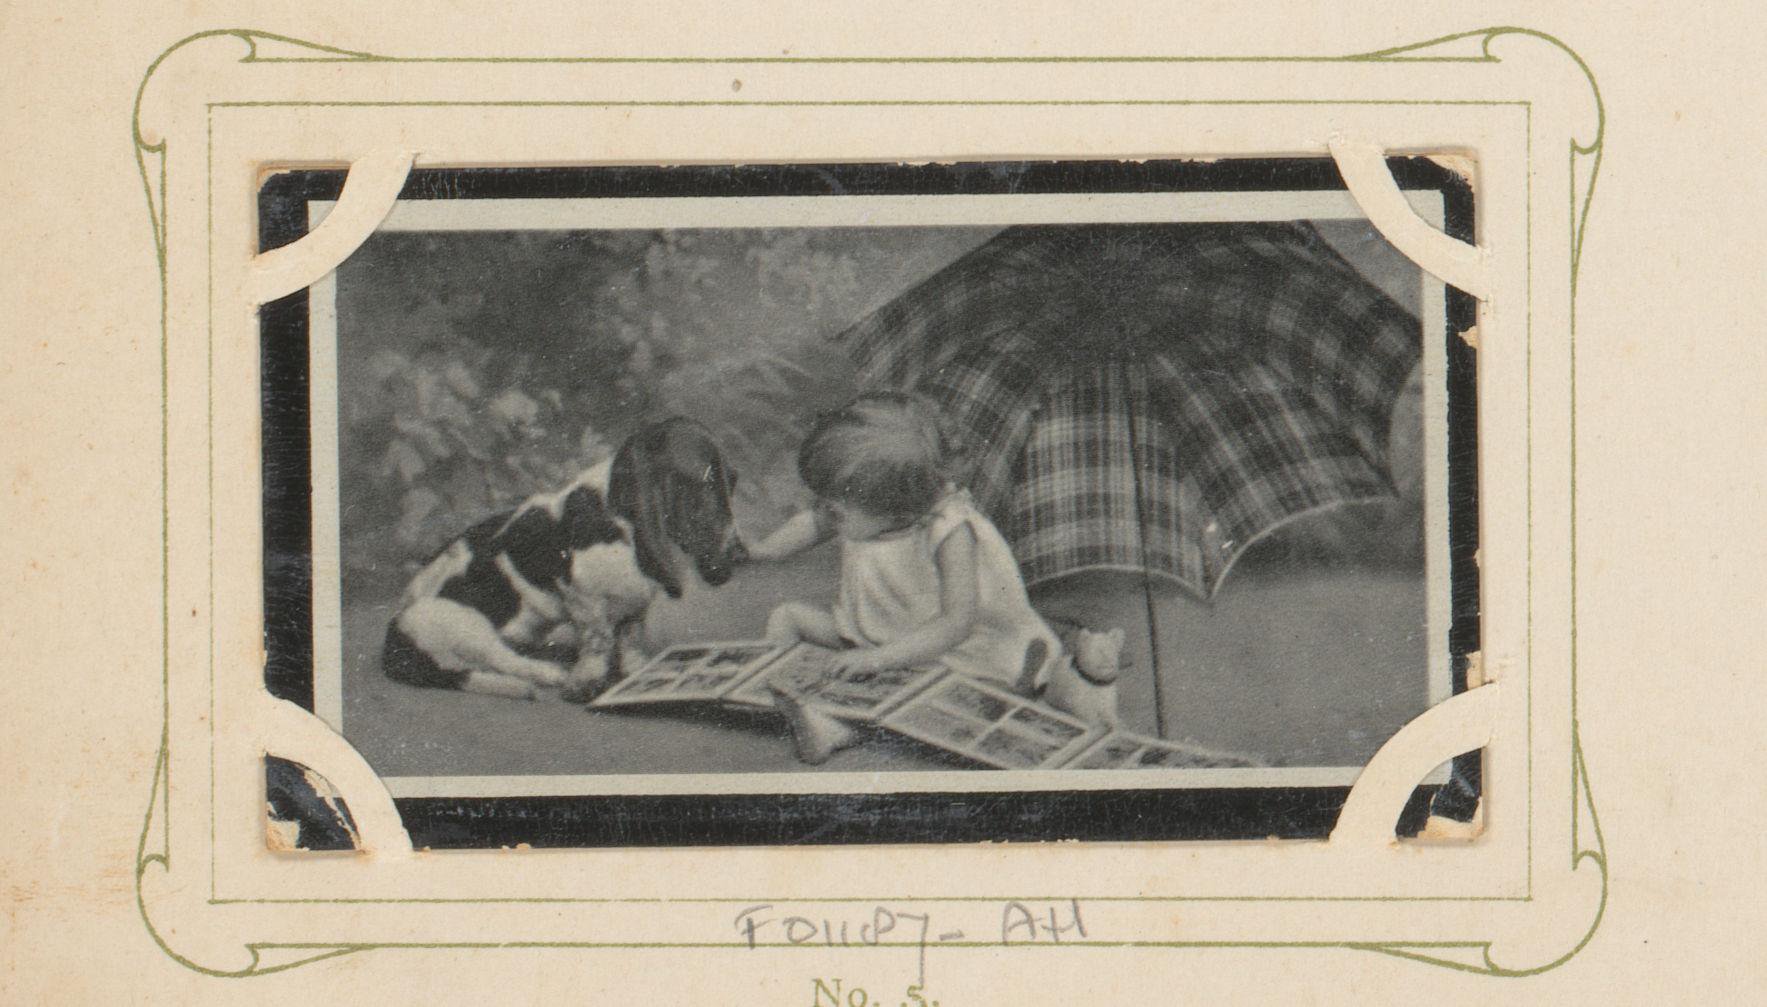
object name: photomechanical print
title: Kind laat een album zien aan een hond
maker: Anonymous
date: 1905-1906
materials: paper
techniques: photograph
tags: reading, tot, toddler ~ the ages of man, dog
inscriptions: inscription: ‘No. 5./ De hond moet het album bezien.’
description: Deze prent maakt deel uit van een album.